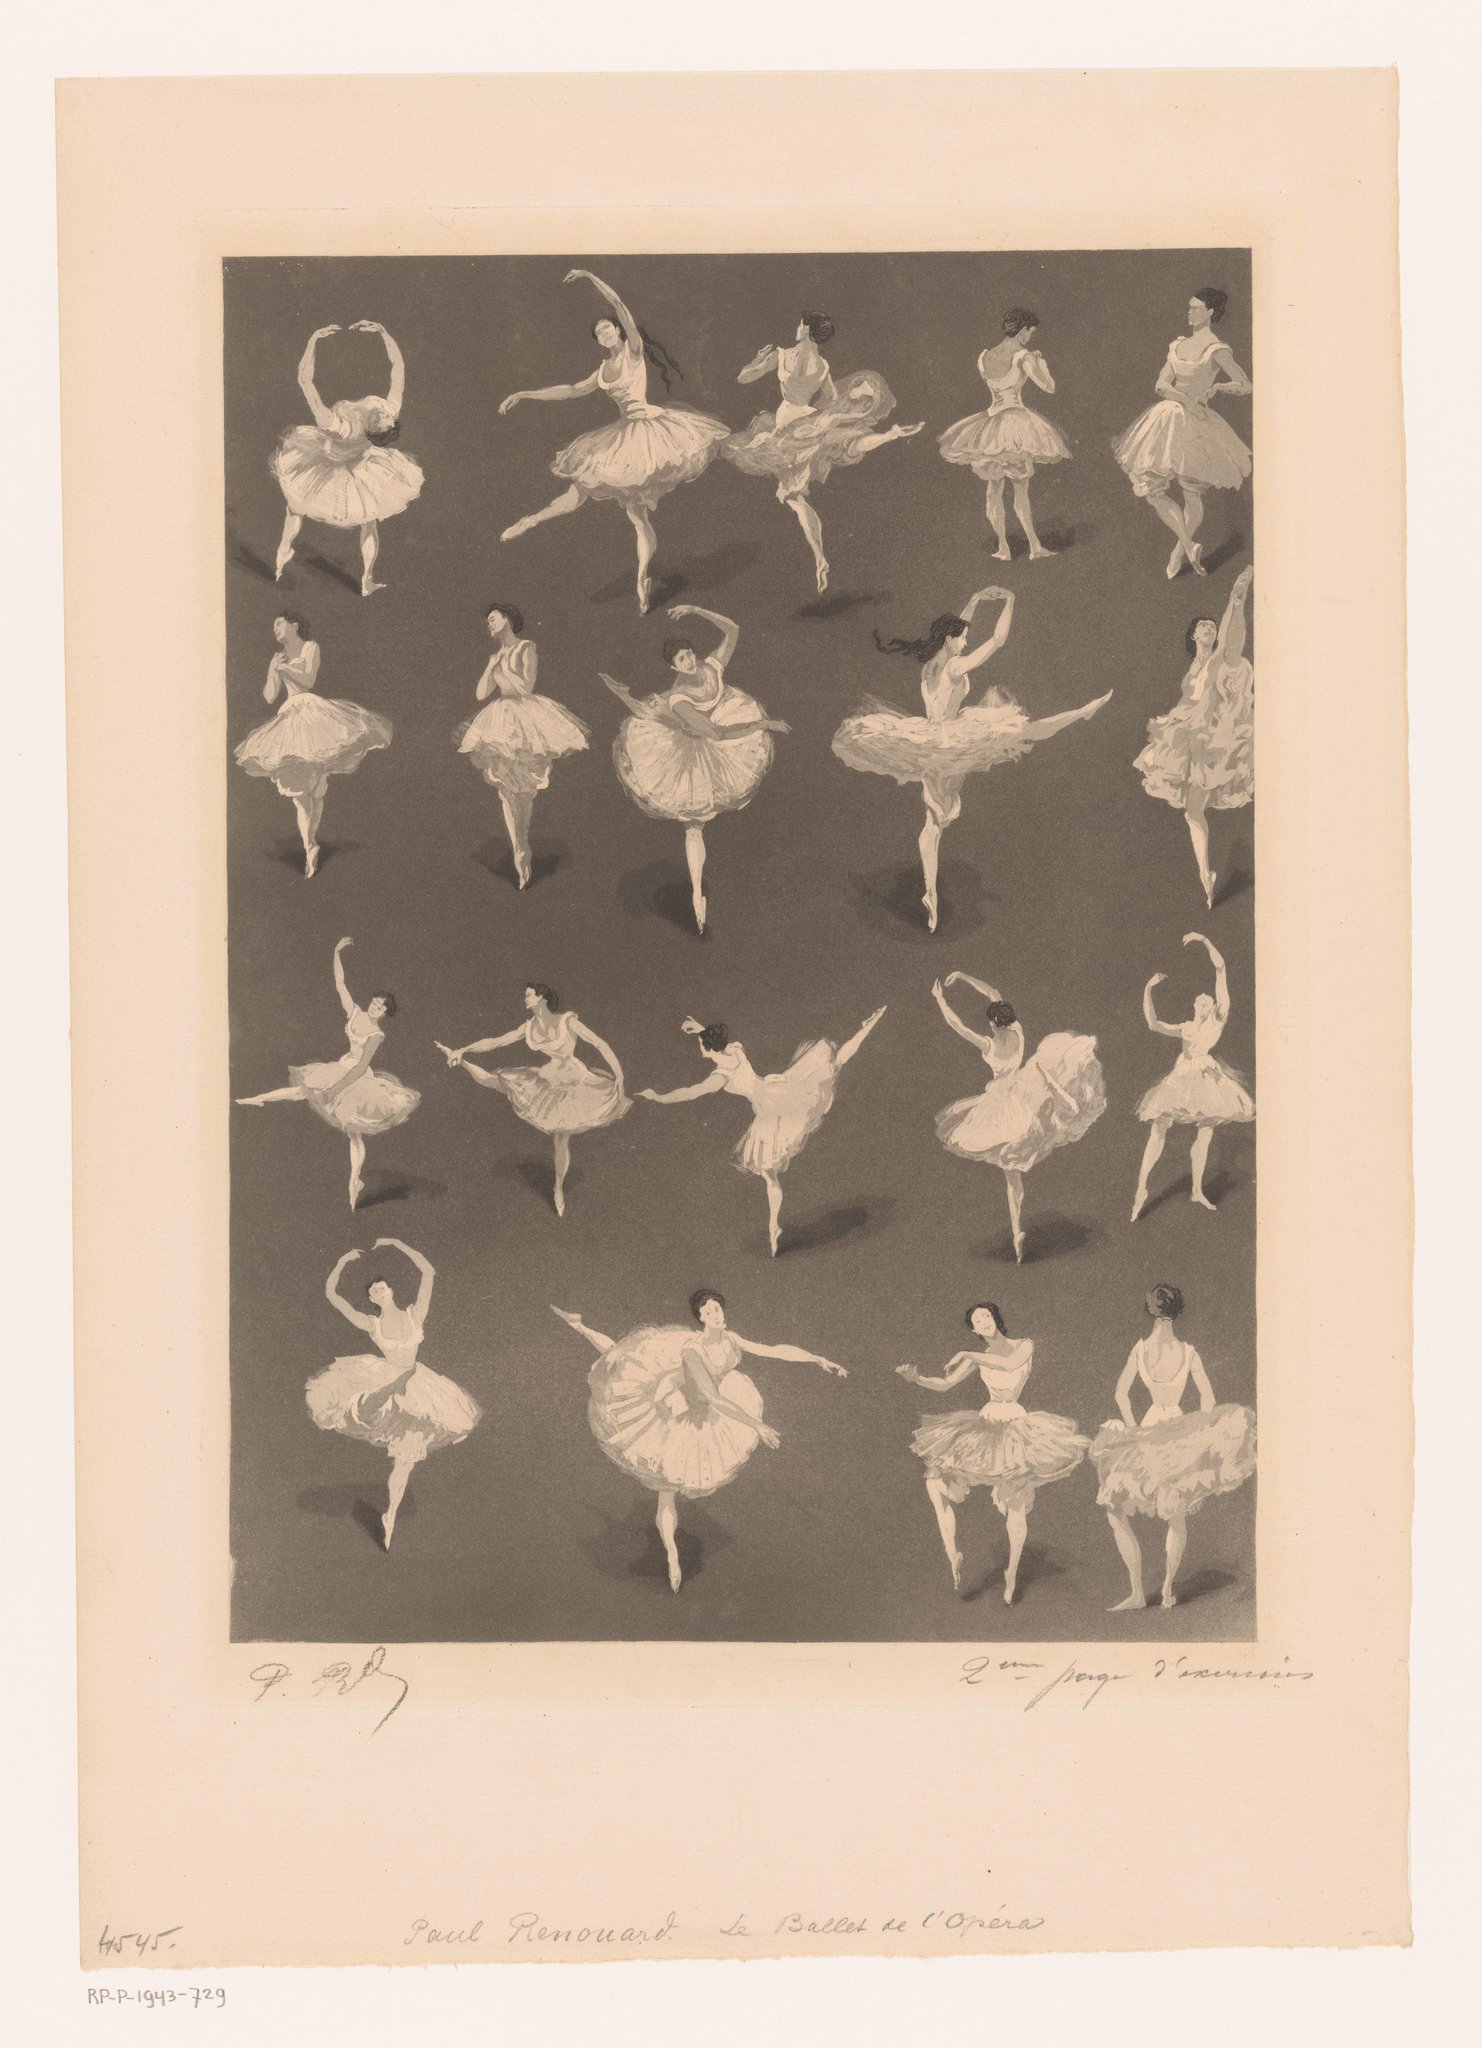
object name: print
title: Negentien balletdanseressen in verschillende posities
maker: paul renouard (1845-1924)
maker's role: painter, print maker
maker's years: 1845-1924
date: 1855-1924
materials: paper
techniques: aquatint, etching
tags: the ballet, ballet performance, female dancer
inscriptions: collector's mark: Lugt 2228